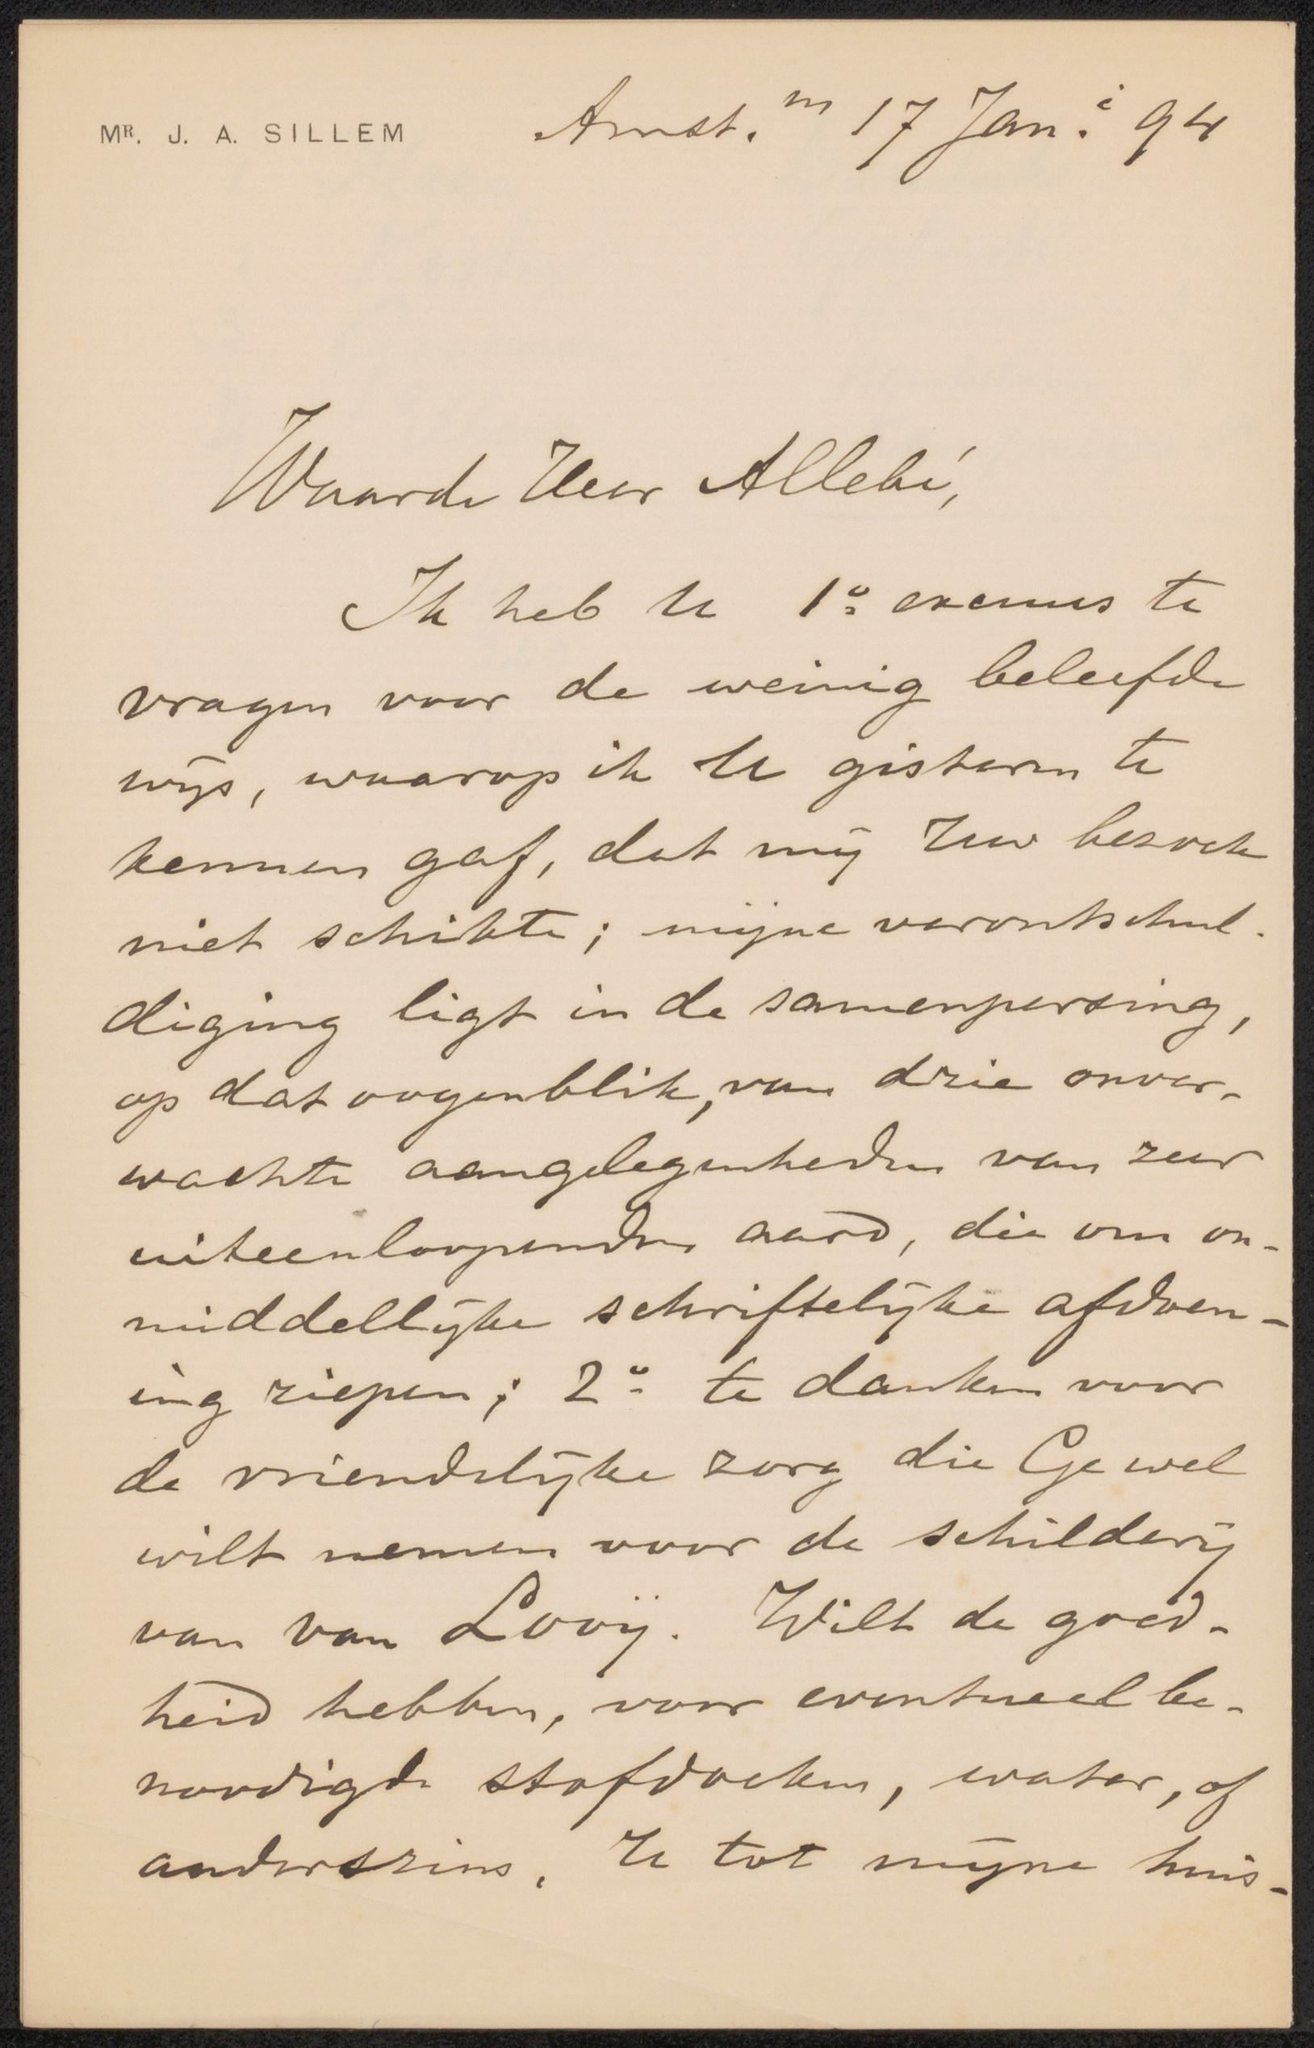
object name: letter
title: Brief aan August Allebé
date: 1894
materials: ink, paper, pencil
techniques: pen, printing, writing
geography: amsterdam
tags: print maker, draughtsman, august allebé, haarlem, painter, jac van looij, painting (including book-illumination, miniature-painting)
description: Brief bevat aantekening van een anonieme schrijver.